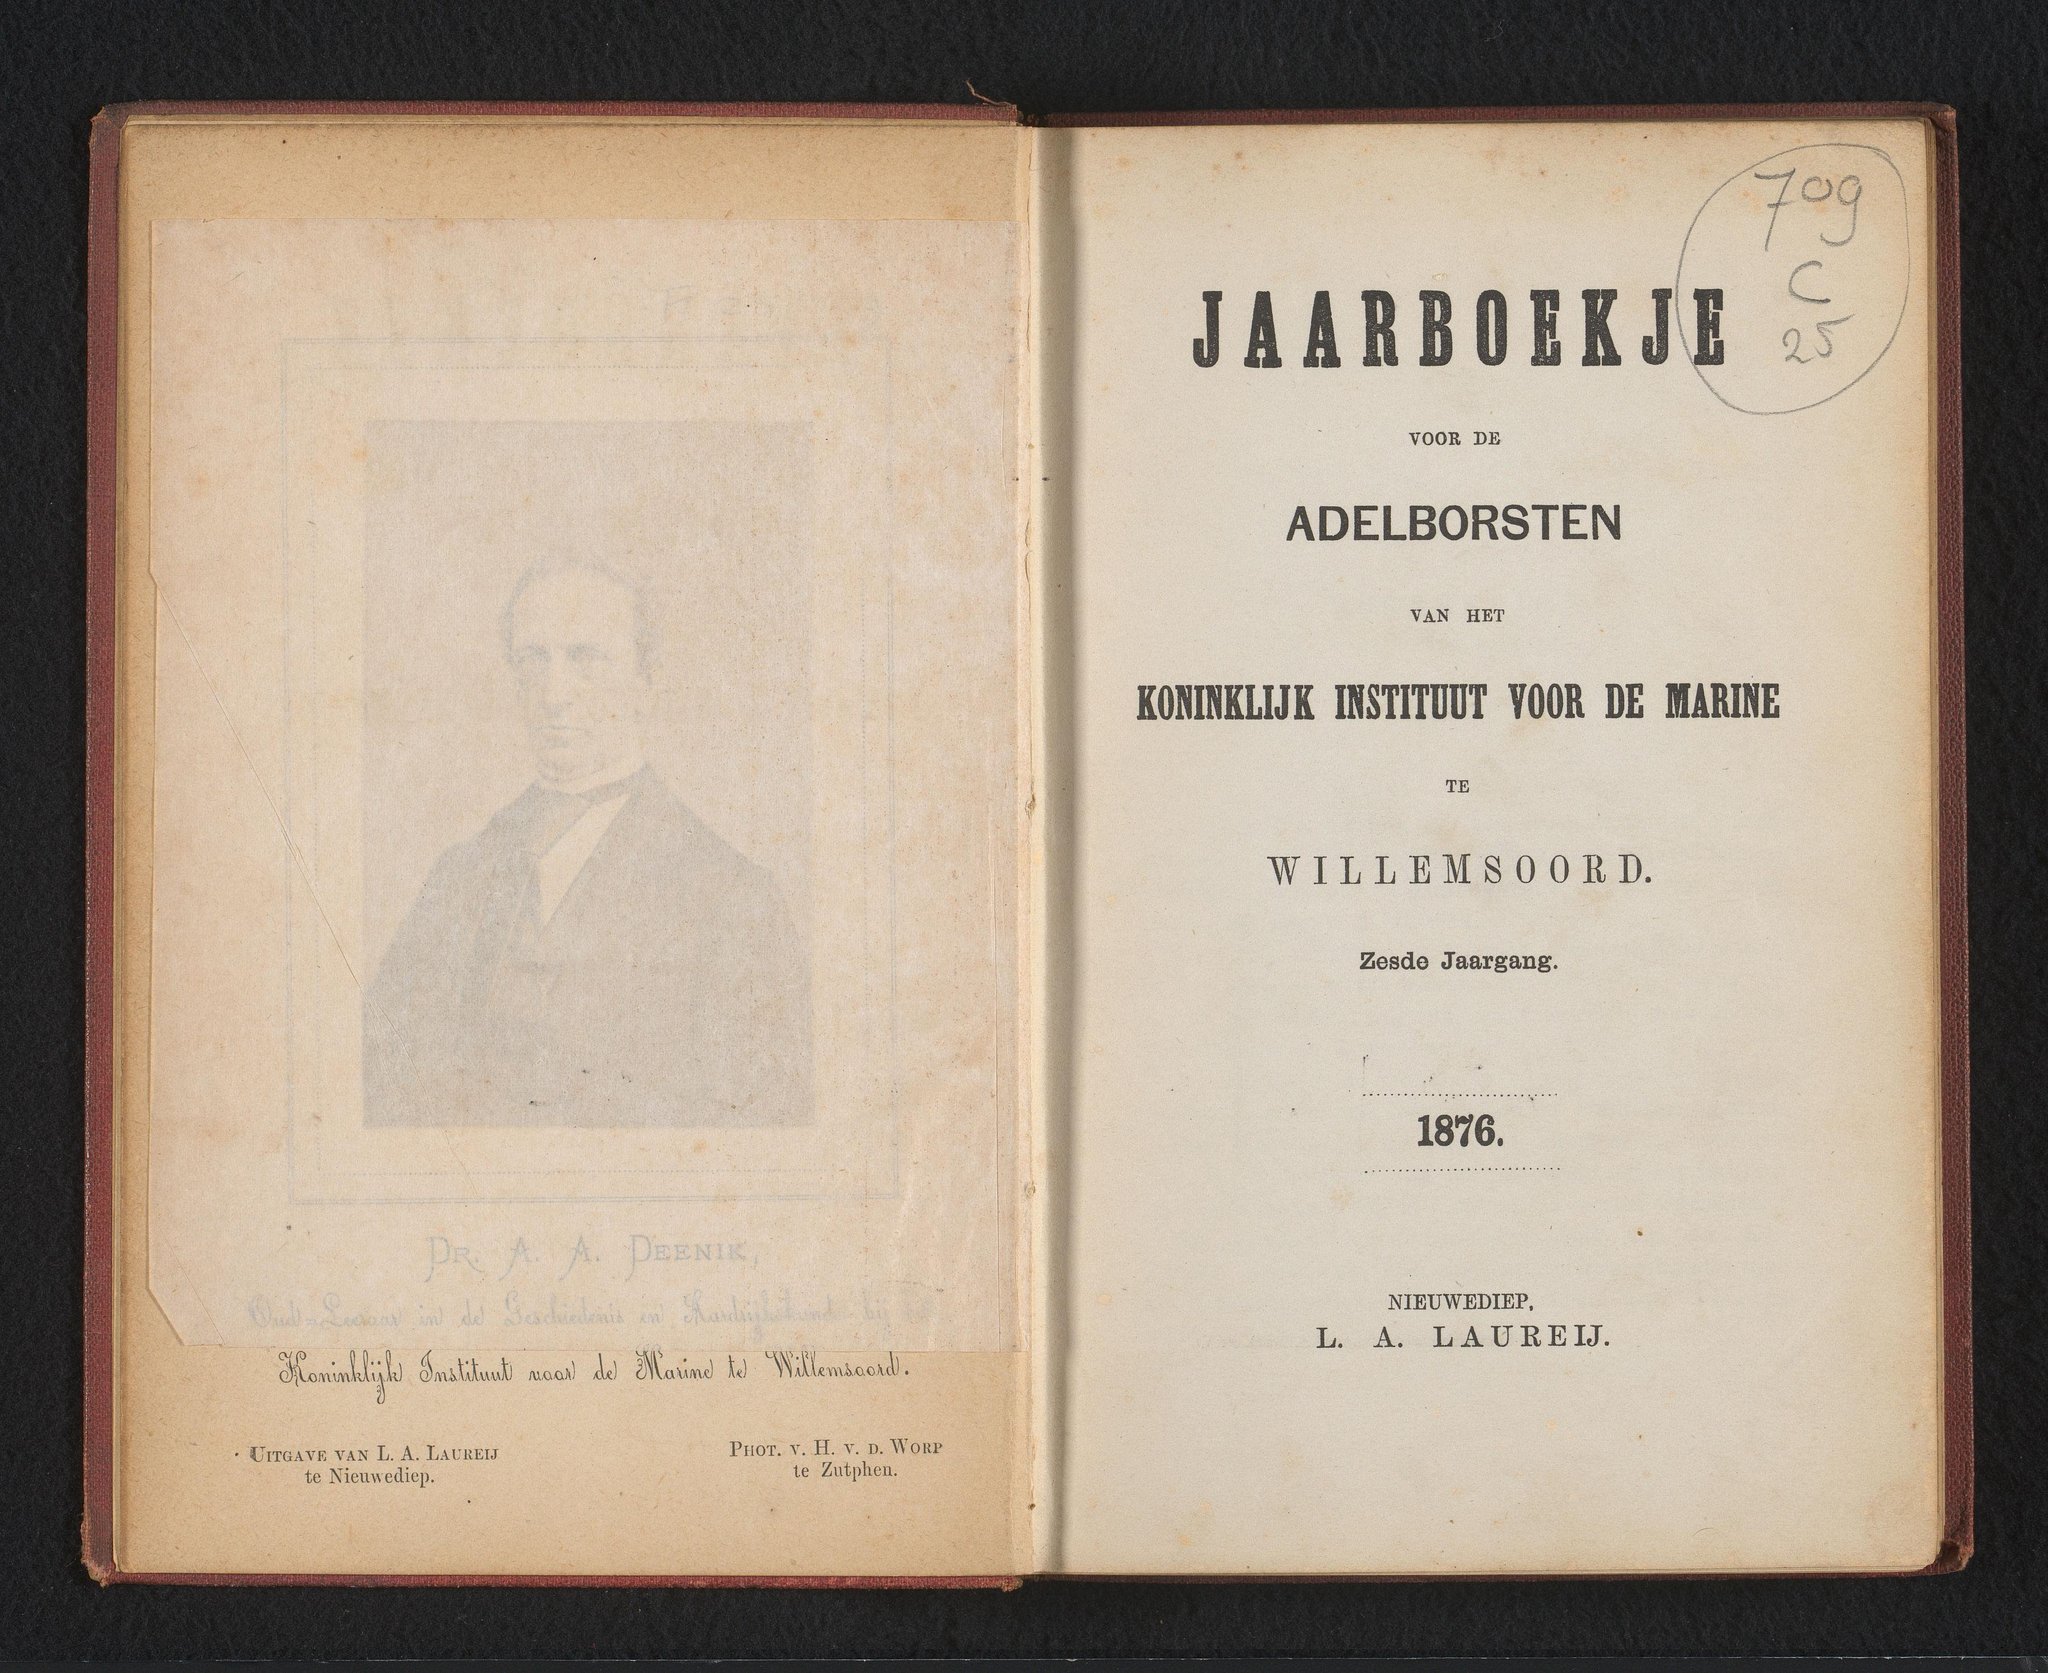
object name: book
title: Jaarboekje voor de Adelborsten van het Koninklijk Instituut voor de Marine te Willemsoord 1876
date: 1876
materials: paper, cardboard, linen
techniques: albumen print, letterpress printing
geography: paris